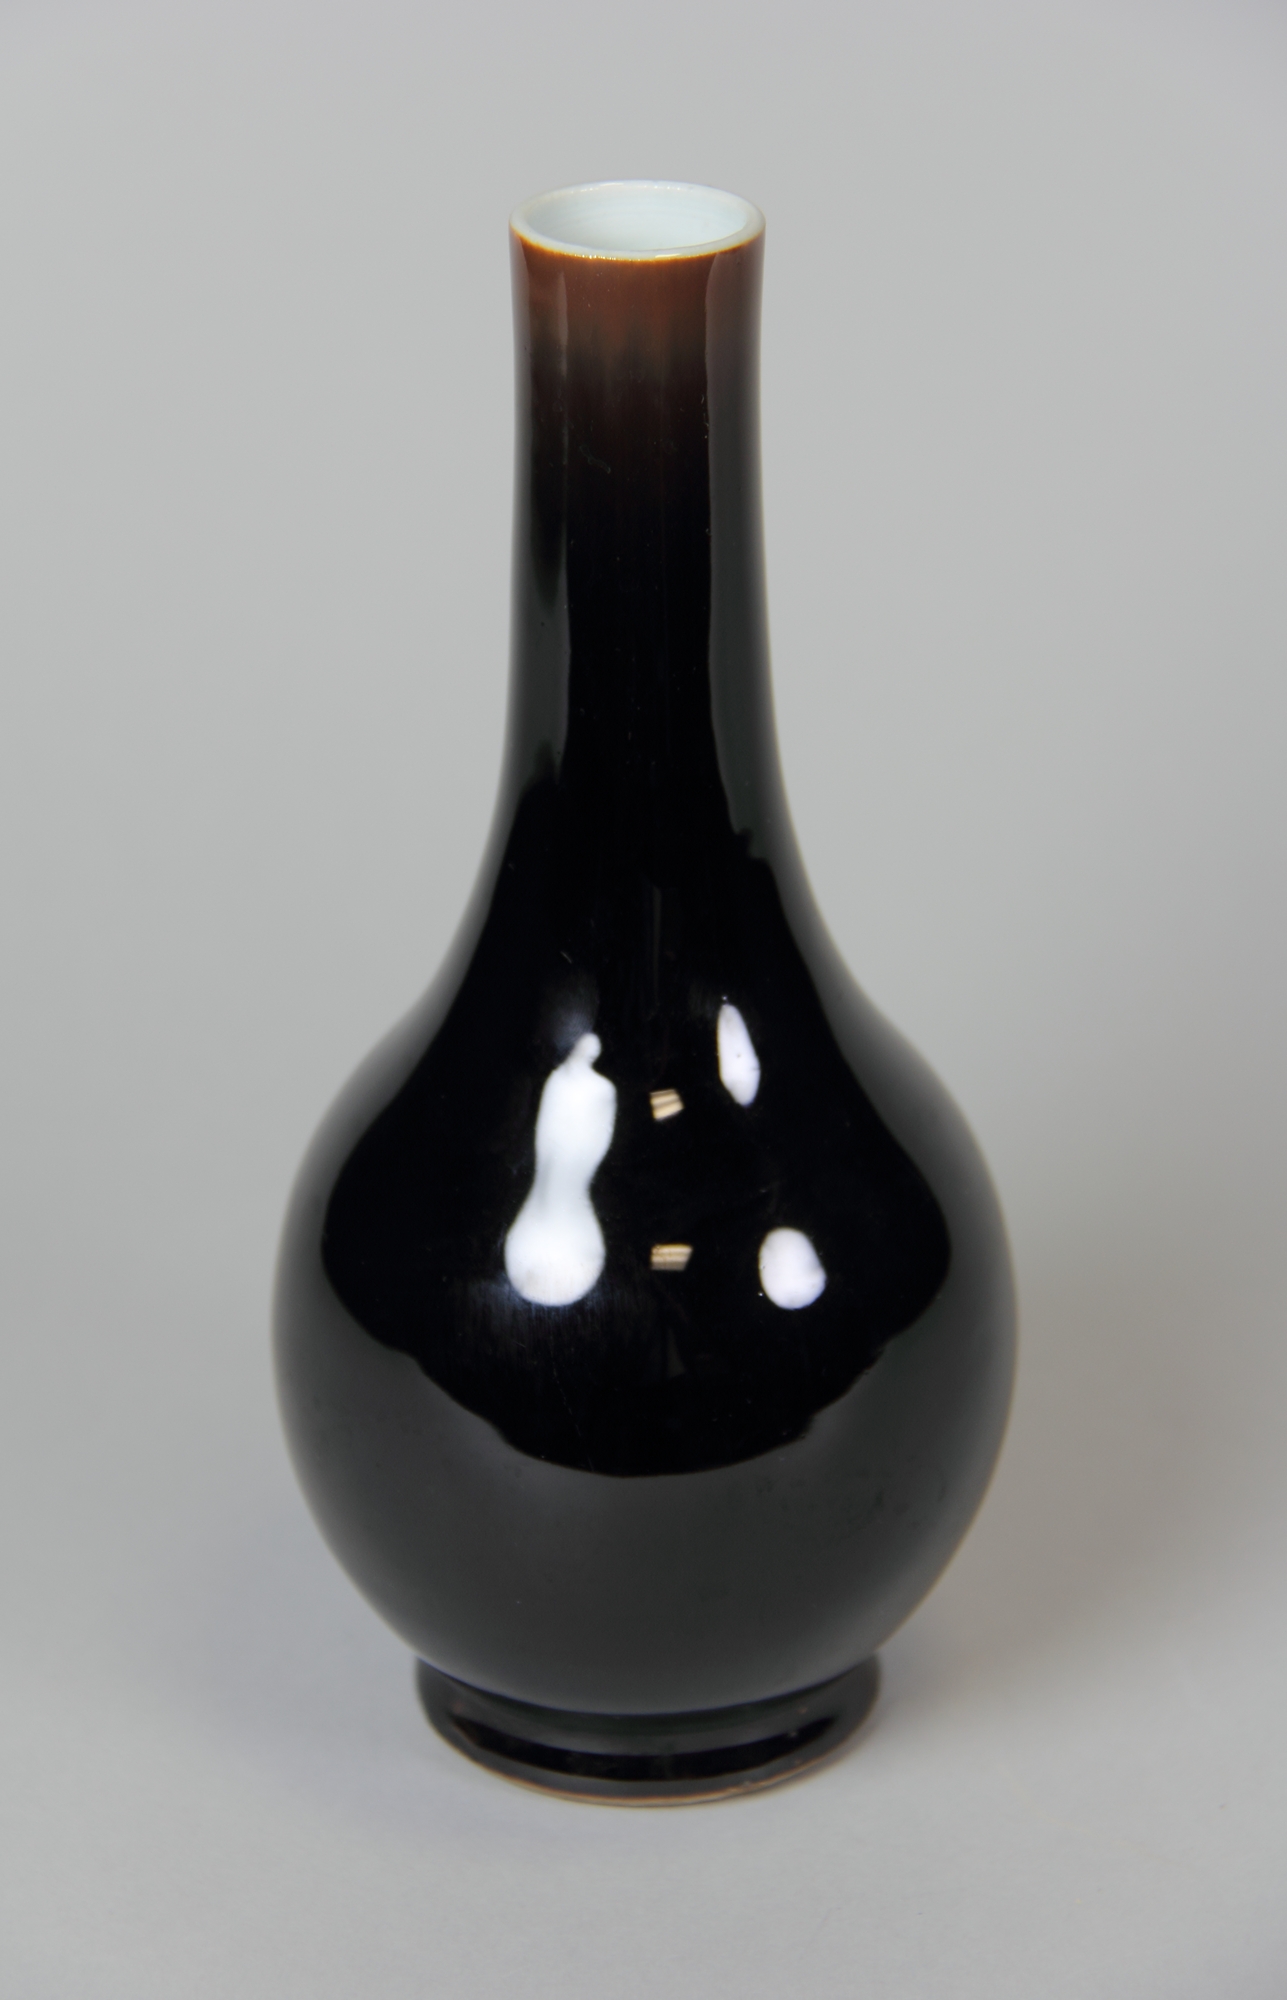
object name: vase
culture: chinese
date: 1801-1850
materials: glaze, porcelain